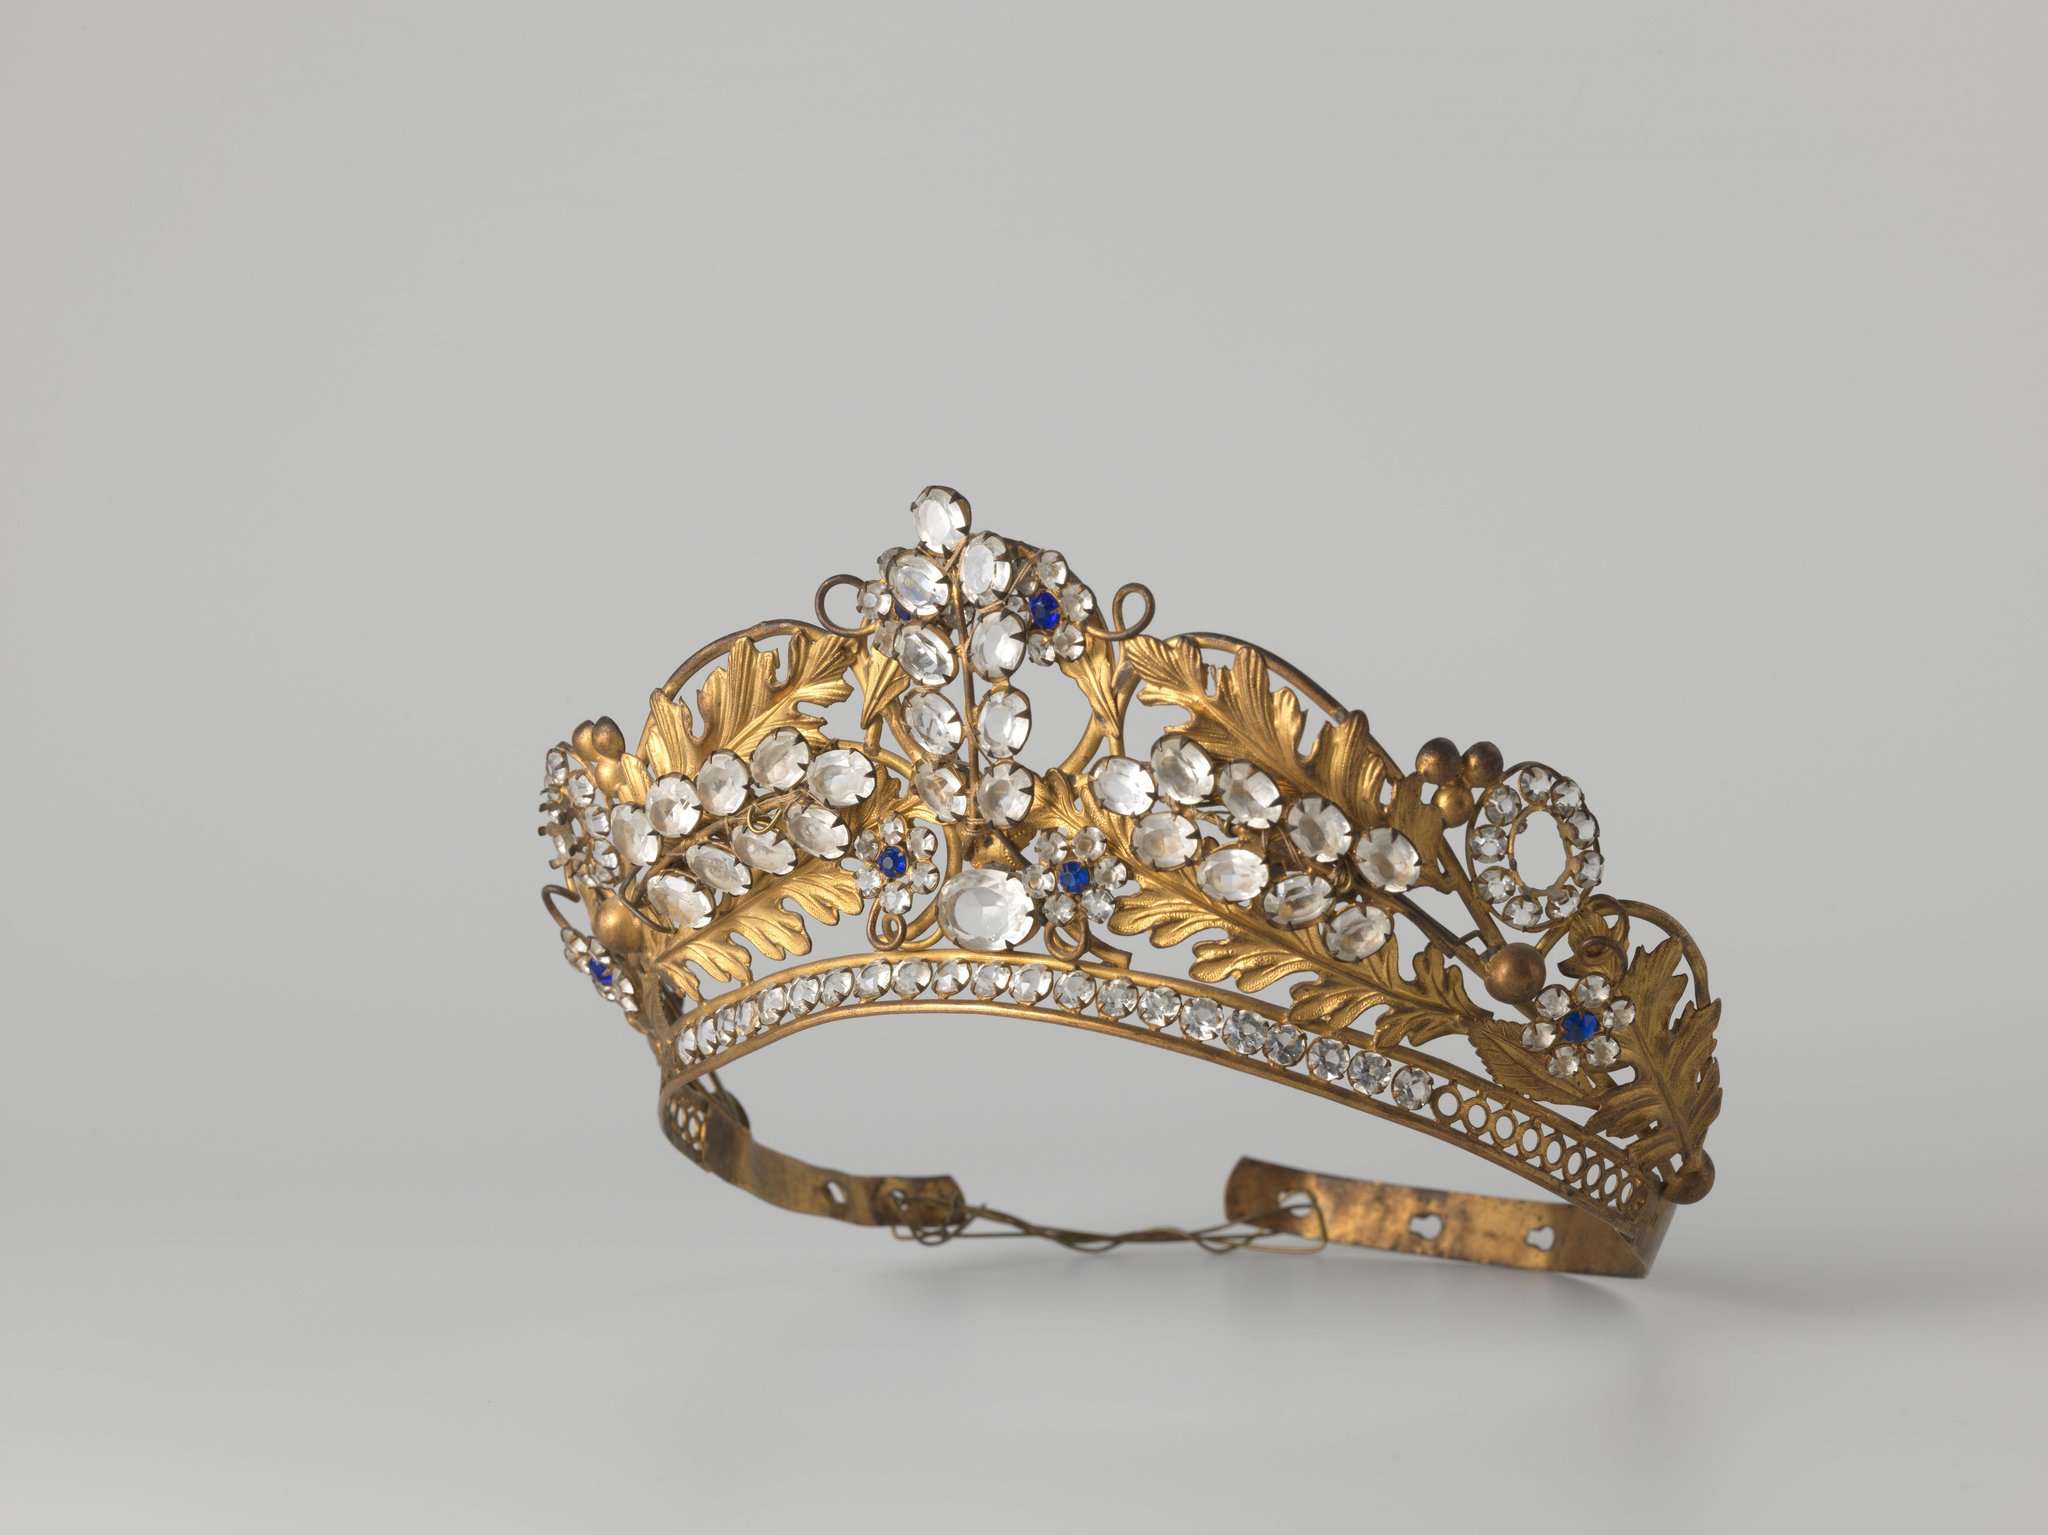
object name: diadem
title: Diadeem van draadwerk, koper en blauwe stenen in de vorm van korenaren, veren en bloem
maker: Anonymous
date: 1900-1950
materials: copper, metal thread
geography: netherlands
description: Diadeem van draadwerk, koper en blauwe stenen. Toneelrekwisiet (?). Korenaren of veren flankeren een bloem.